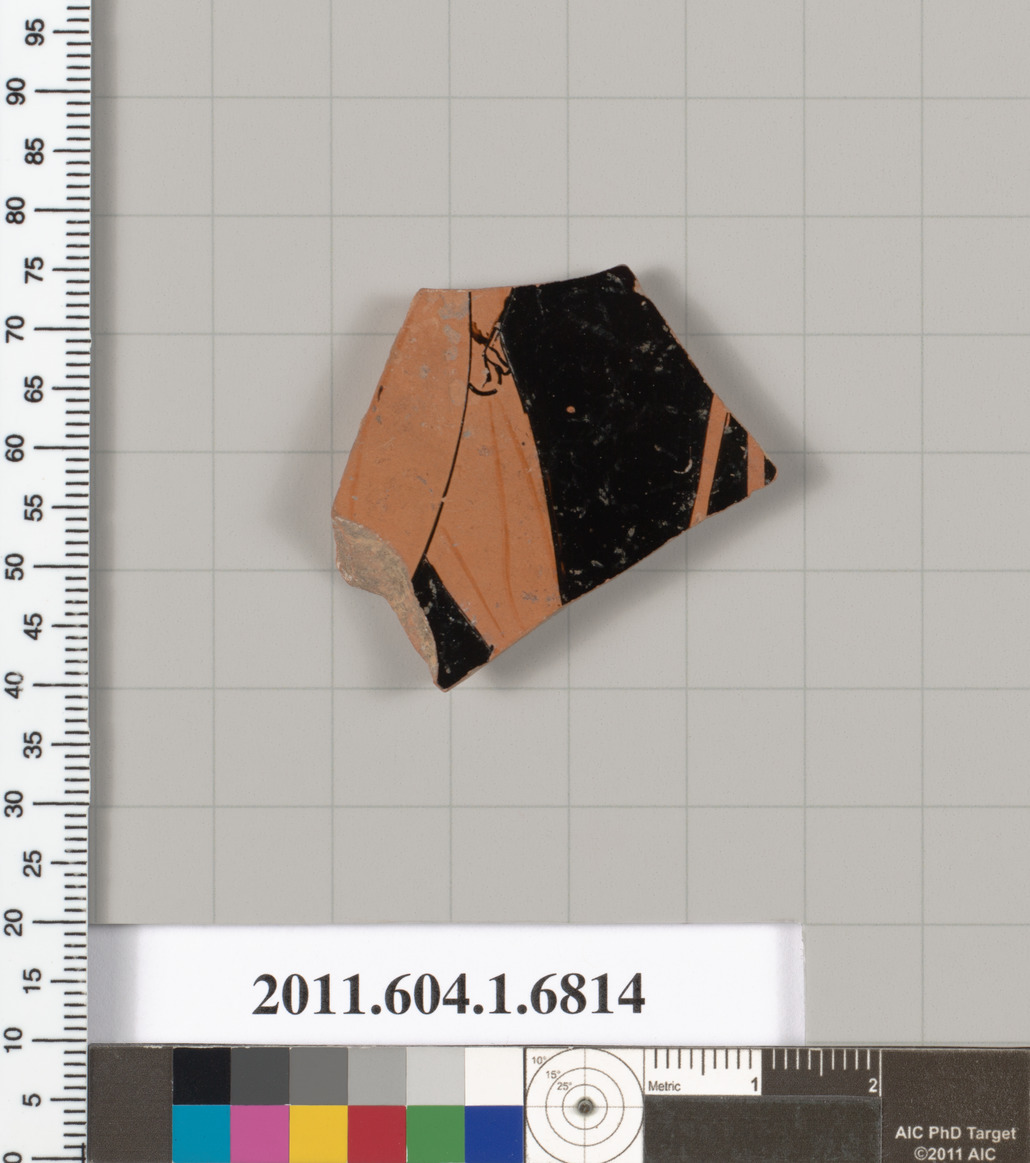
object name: kylix fragment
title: Terracotta fragment of a kylix (drinking cup)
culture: greek, attic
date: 490-470 BCE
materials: terracotta